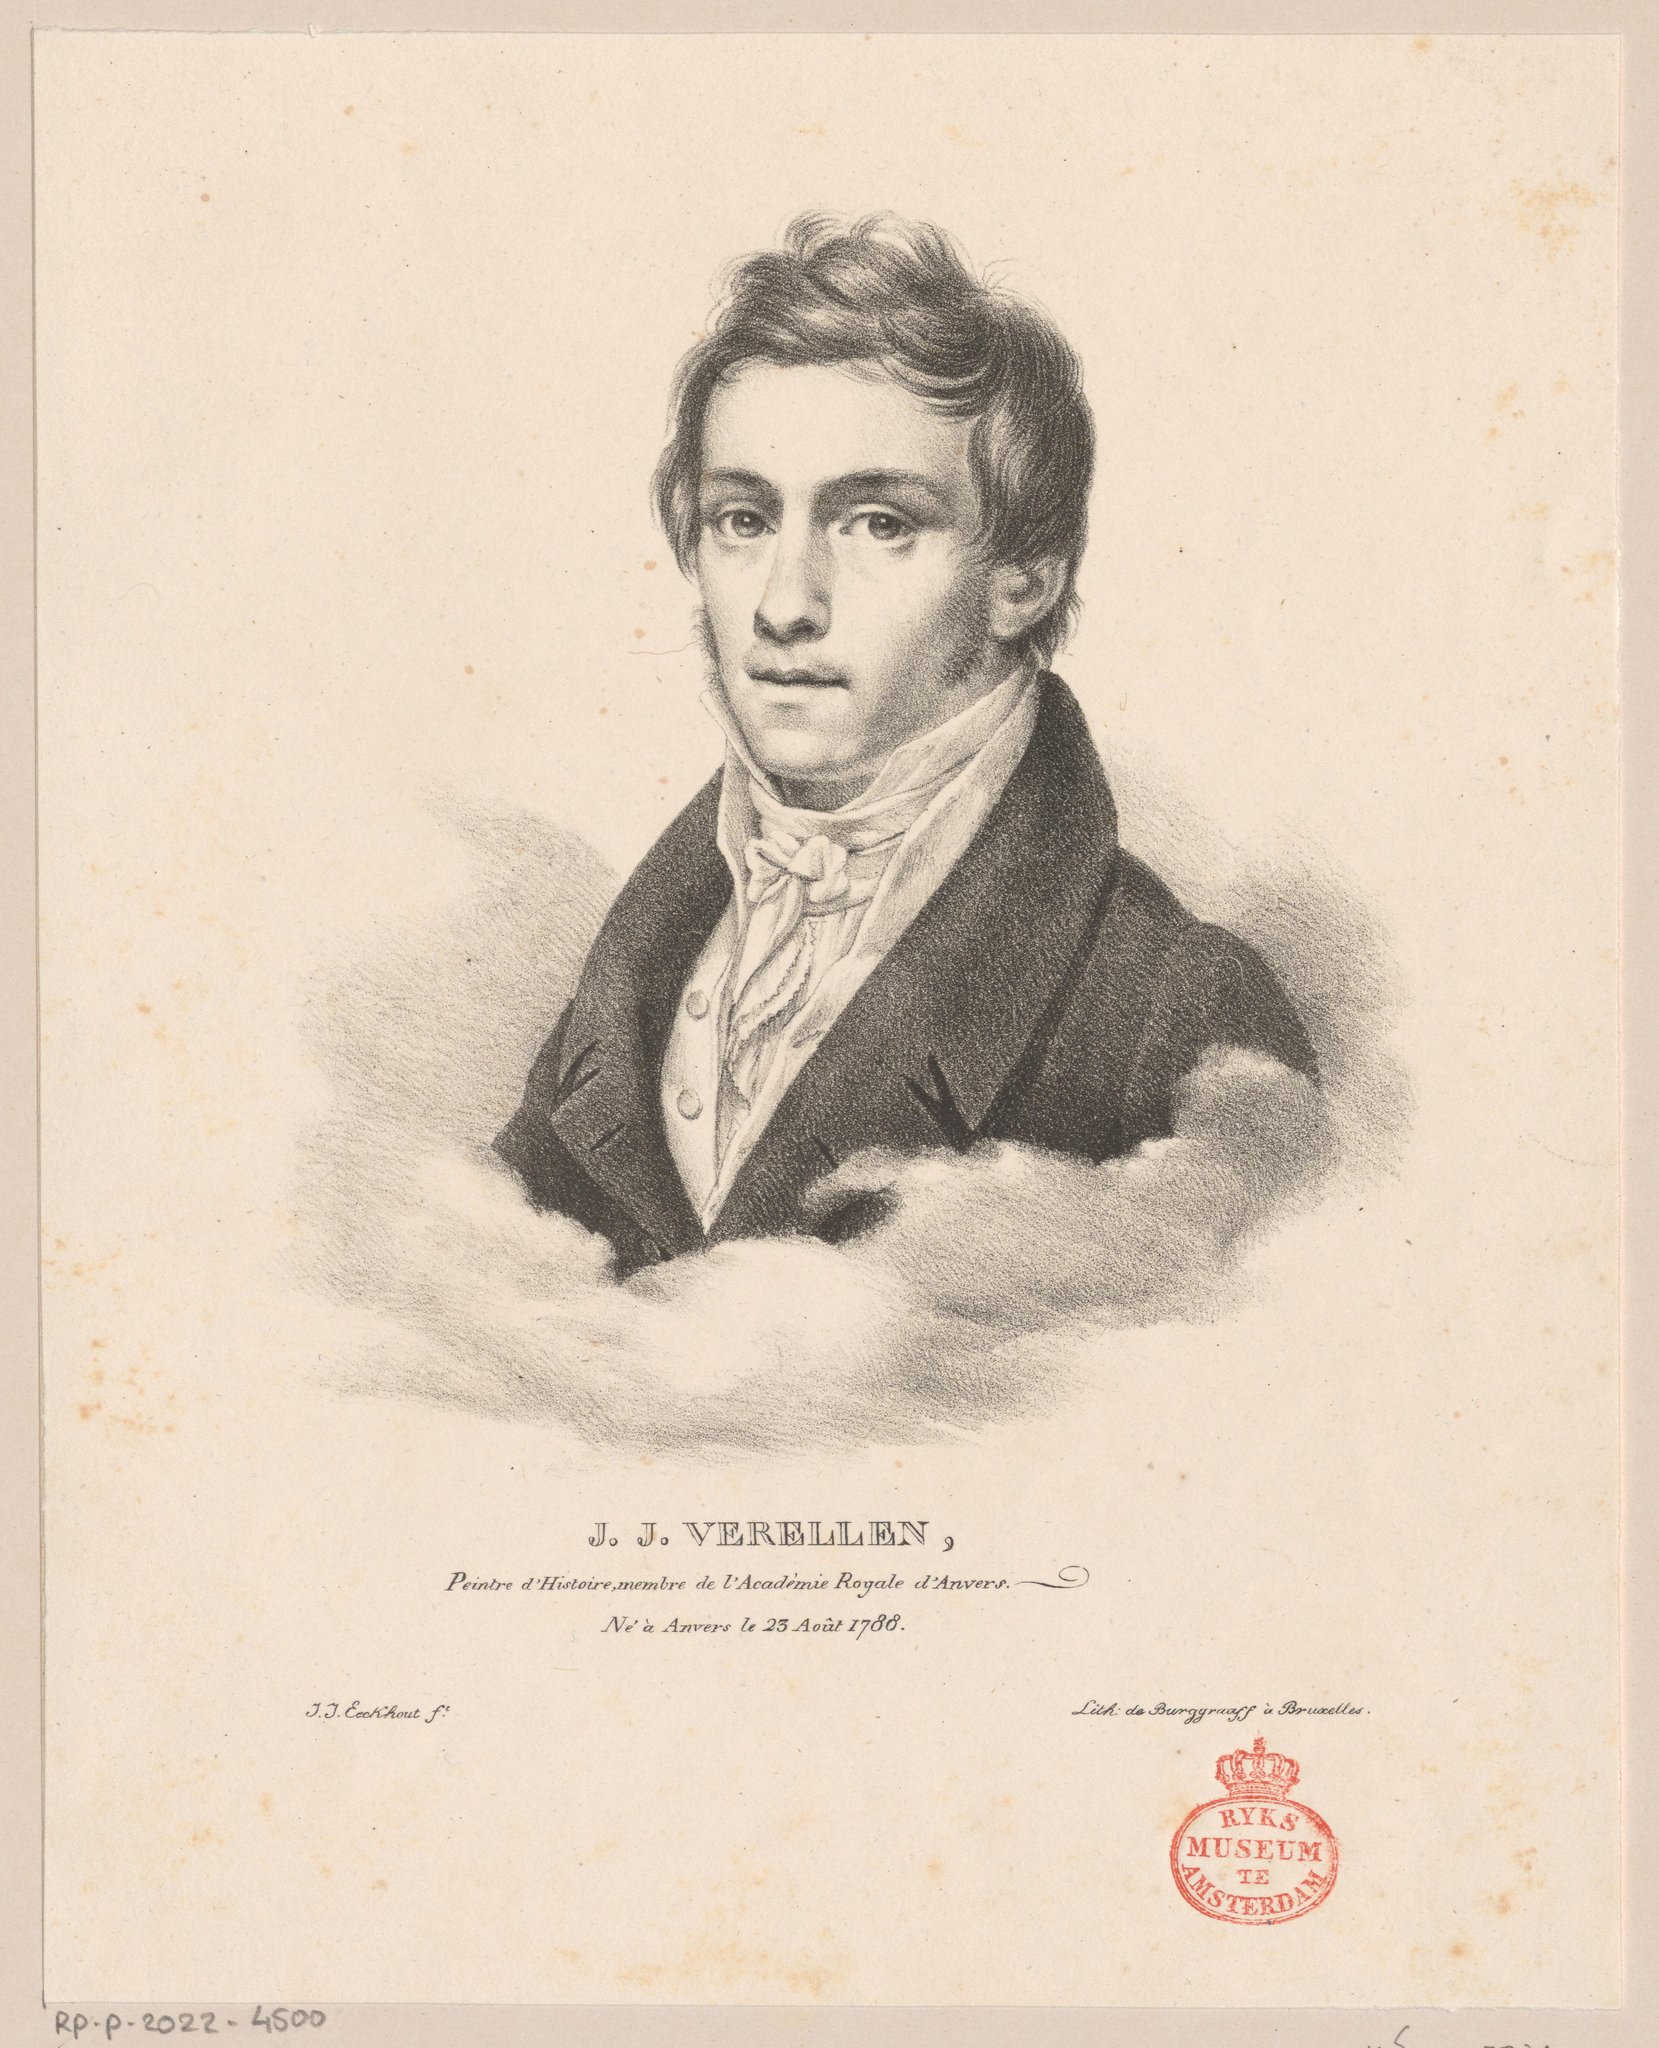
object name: print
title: Portraits des artistes modernes nés dans le Royaume des Pays-Bas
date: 1822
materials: paper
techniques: lithograph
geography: brussels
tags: antwerp, jean joseph verellen, historical persons, portrait, self-portrait of painter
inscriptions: collector's mark: Lugt 12